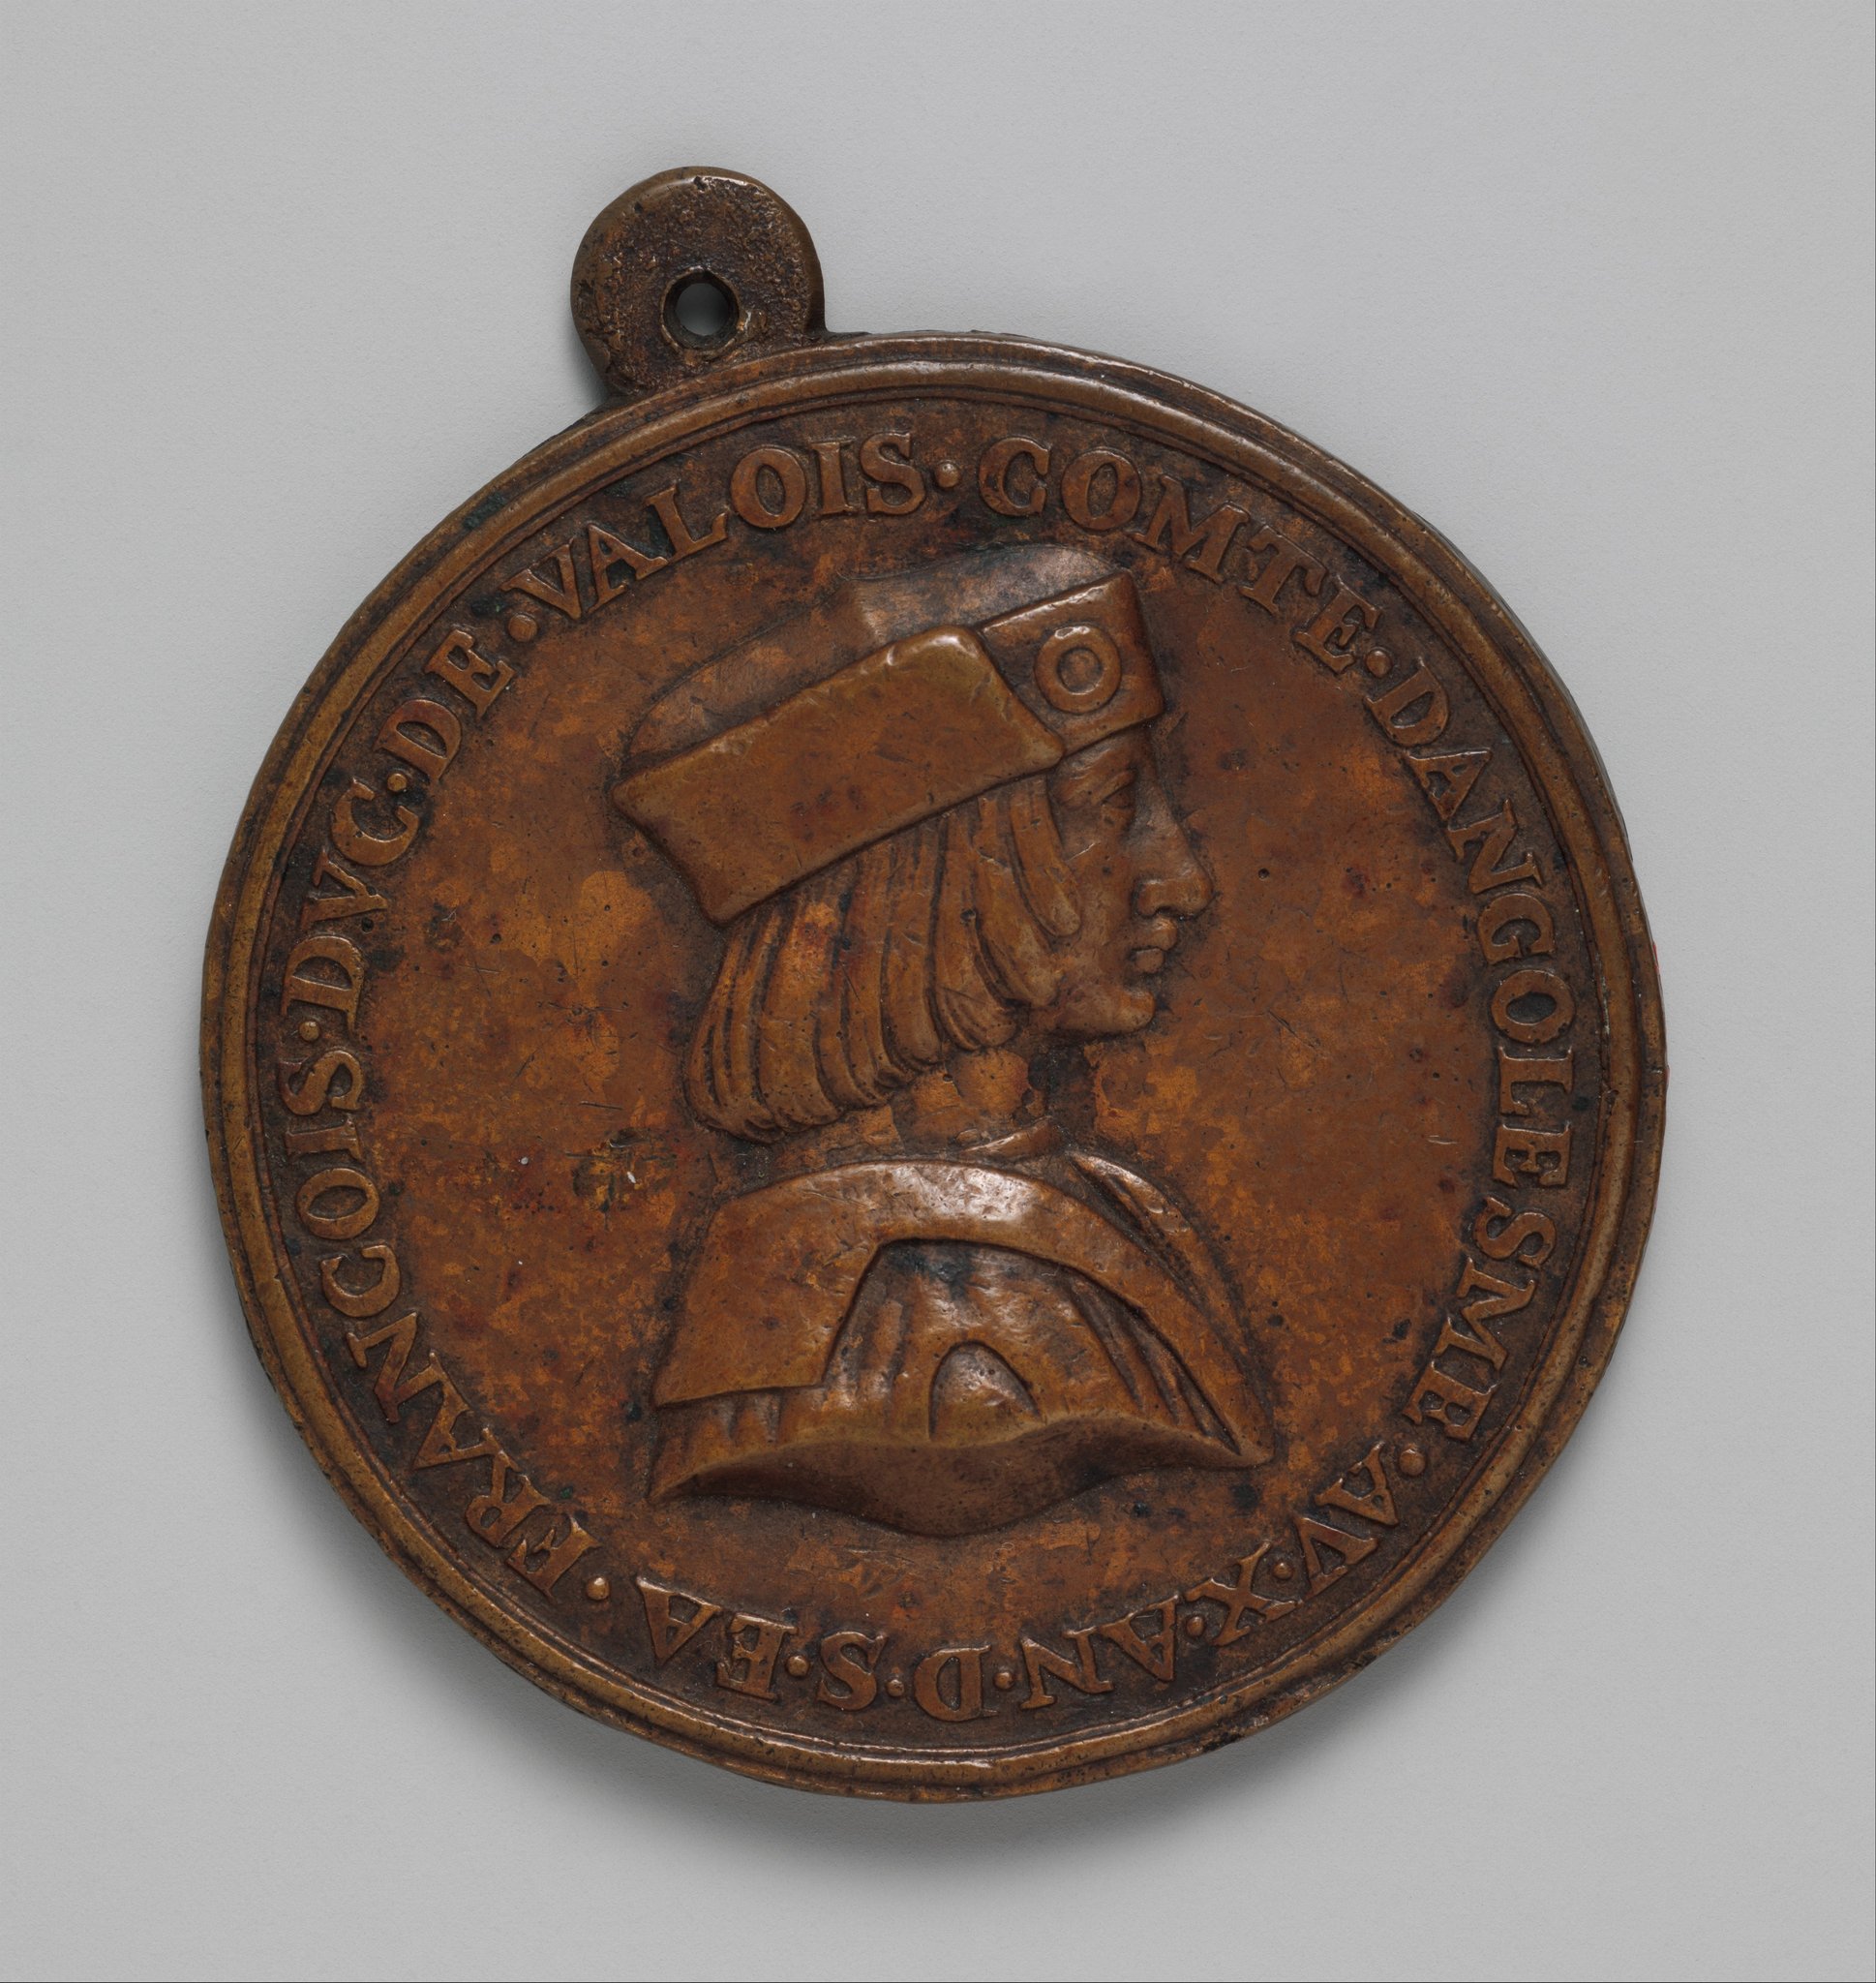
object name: medal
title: Francis, Duke of Valois, later Francis I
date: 1504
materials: bronze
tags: men,profiles,salamanders